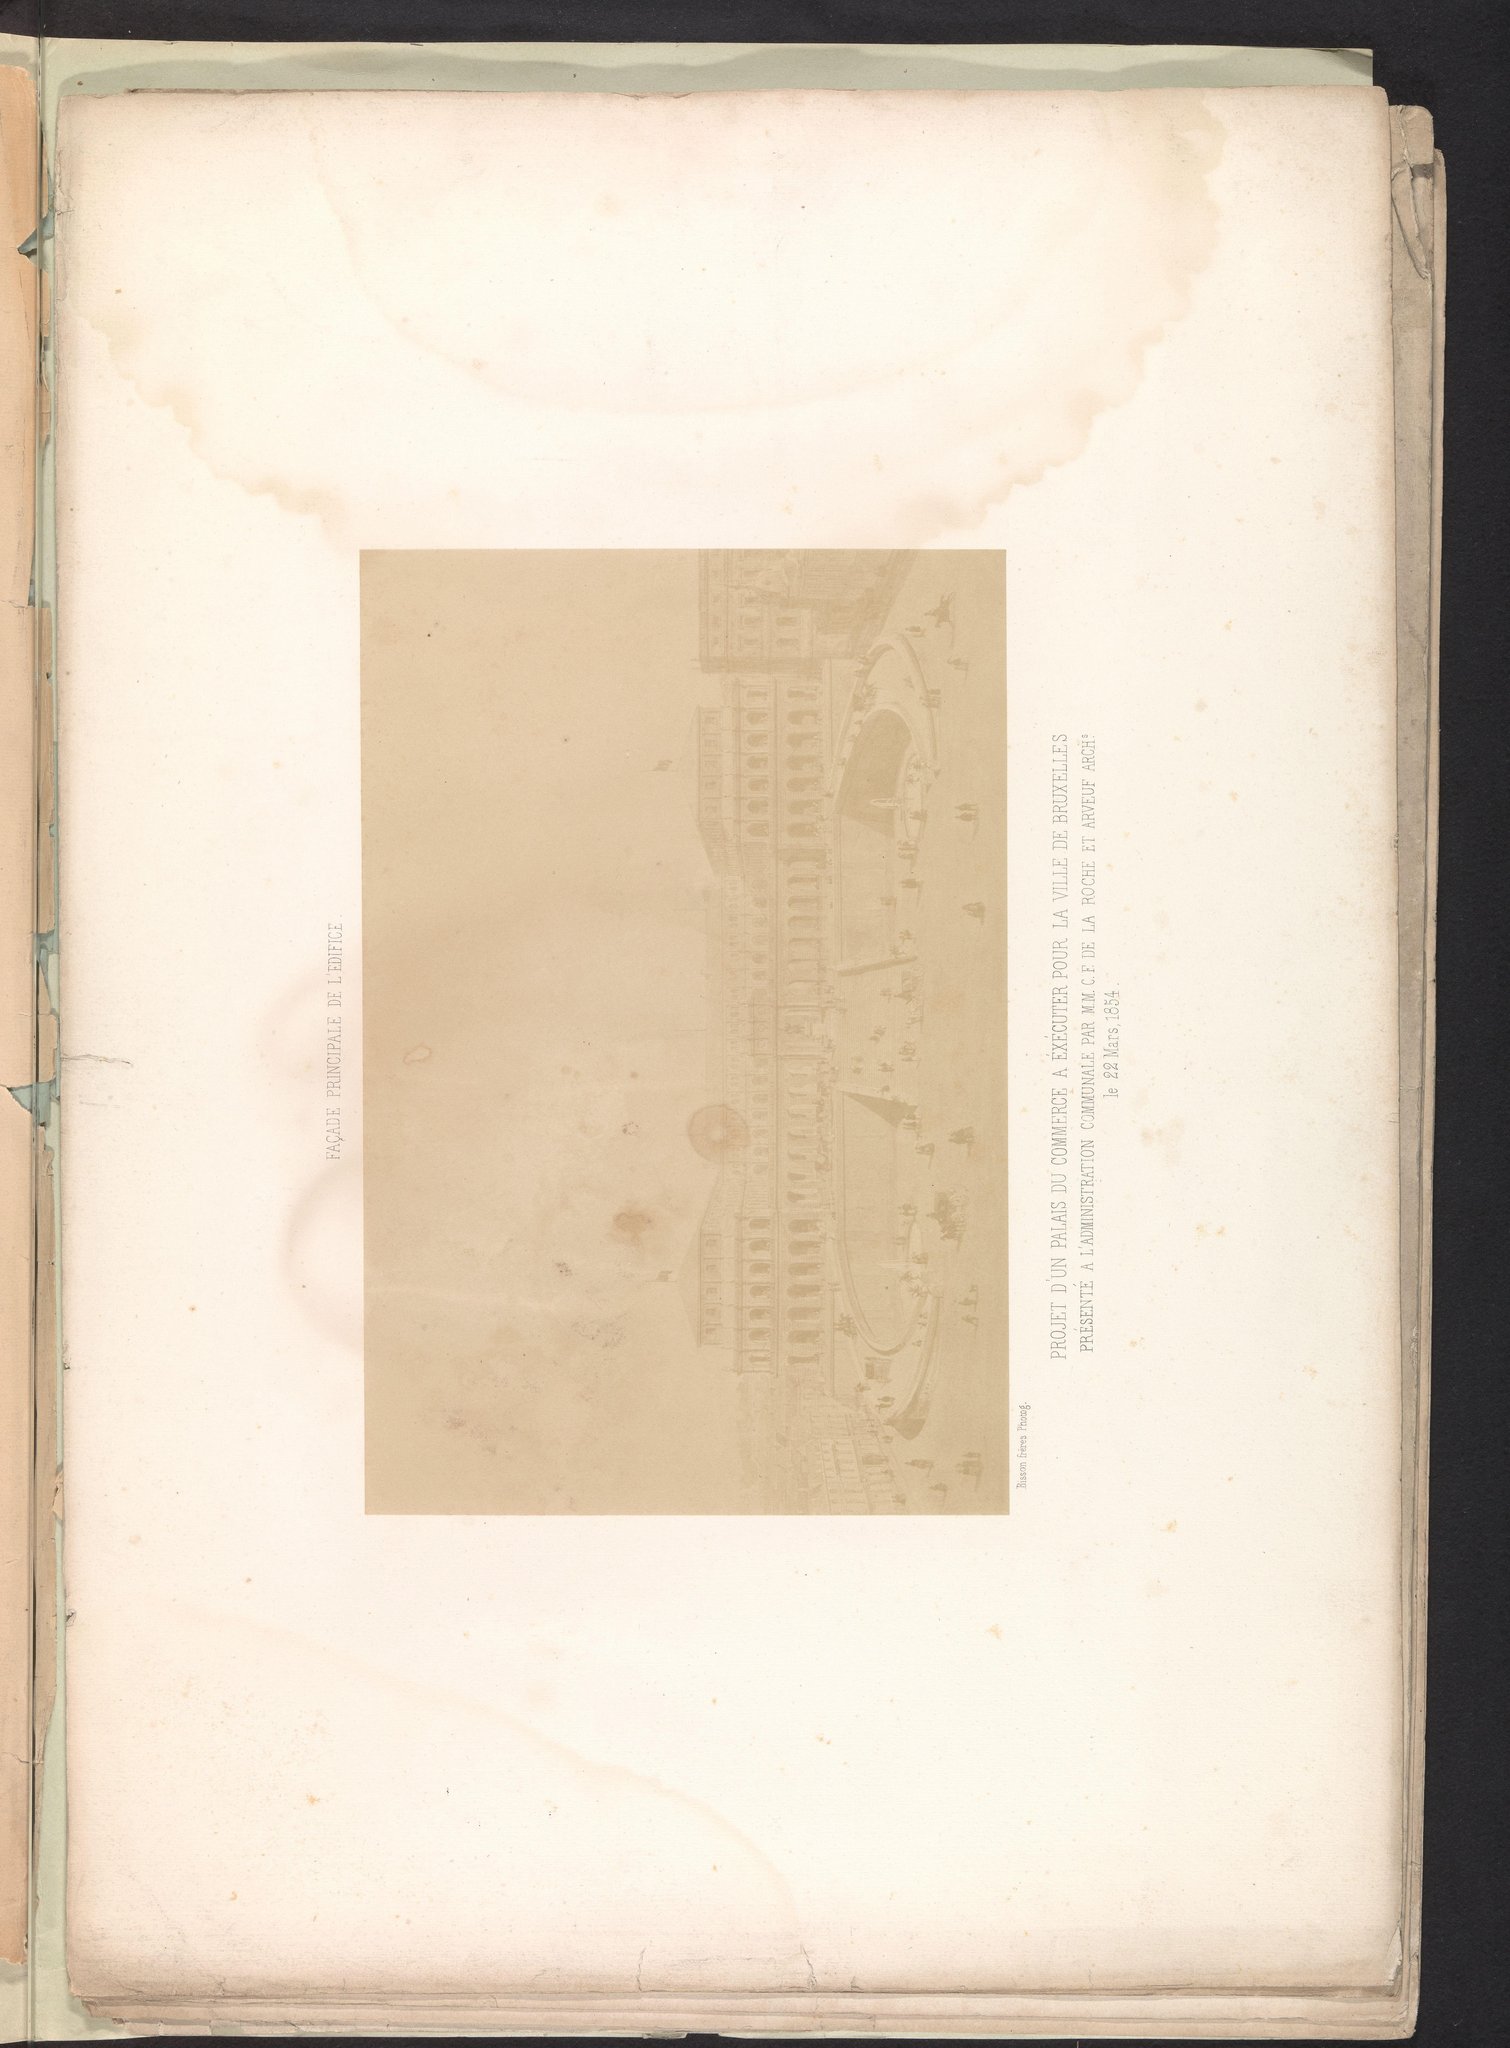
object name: page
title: Fotoreproductie van een tekening, voorstellende de voorgevel van een handelsgebouw te Brussel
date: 1853-1854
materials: photographic support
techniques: albumen print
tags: chamber of commerce, façade (of house or building)